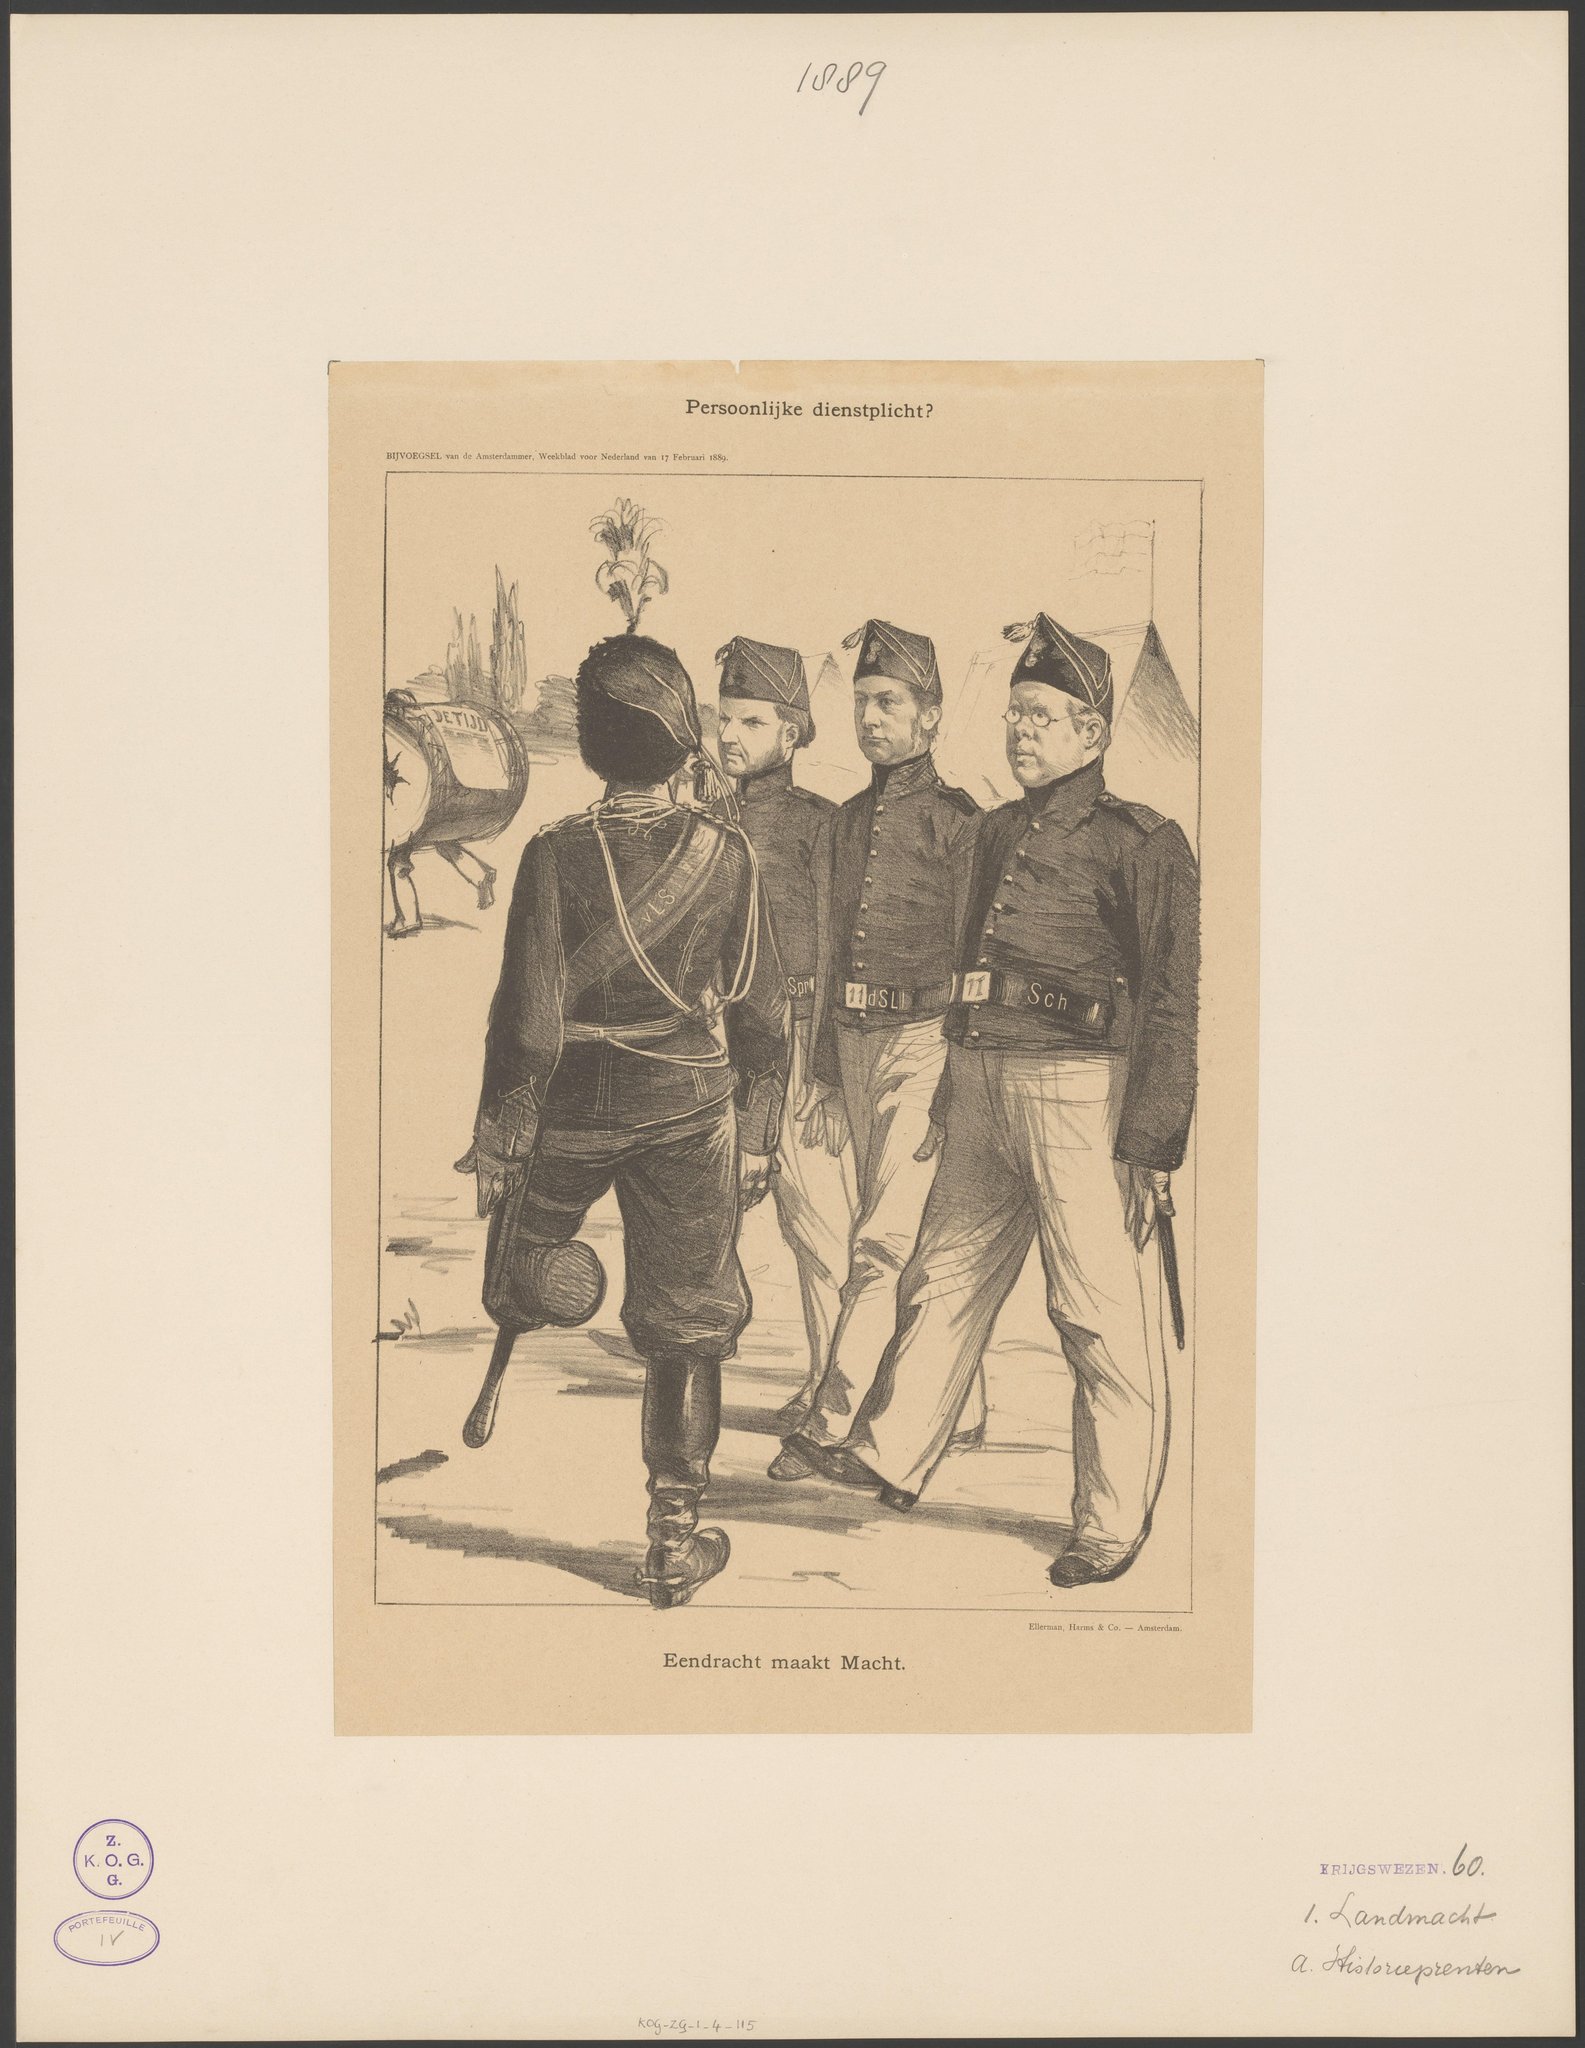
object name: cartoon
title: Persoonlijke dienstplicht? / Eendracht maakt Macht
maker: johan braakensiek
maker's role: draughtsman, print maker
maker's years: 1858-1940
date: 1889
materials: paper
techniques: lithograph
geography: amsterdam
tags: jonkheer alexander frederik de savornin lohman, rome, priest, herman johannes aloysius maria schaepman, military service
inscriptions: collector's mark: Lugt 1641, collector's mark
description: Verschenen als bijvoegsel bij De Amsterdammer van 17 februari 1889.